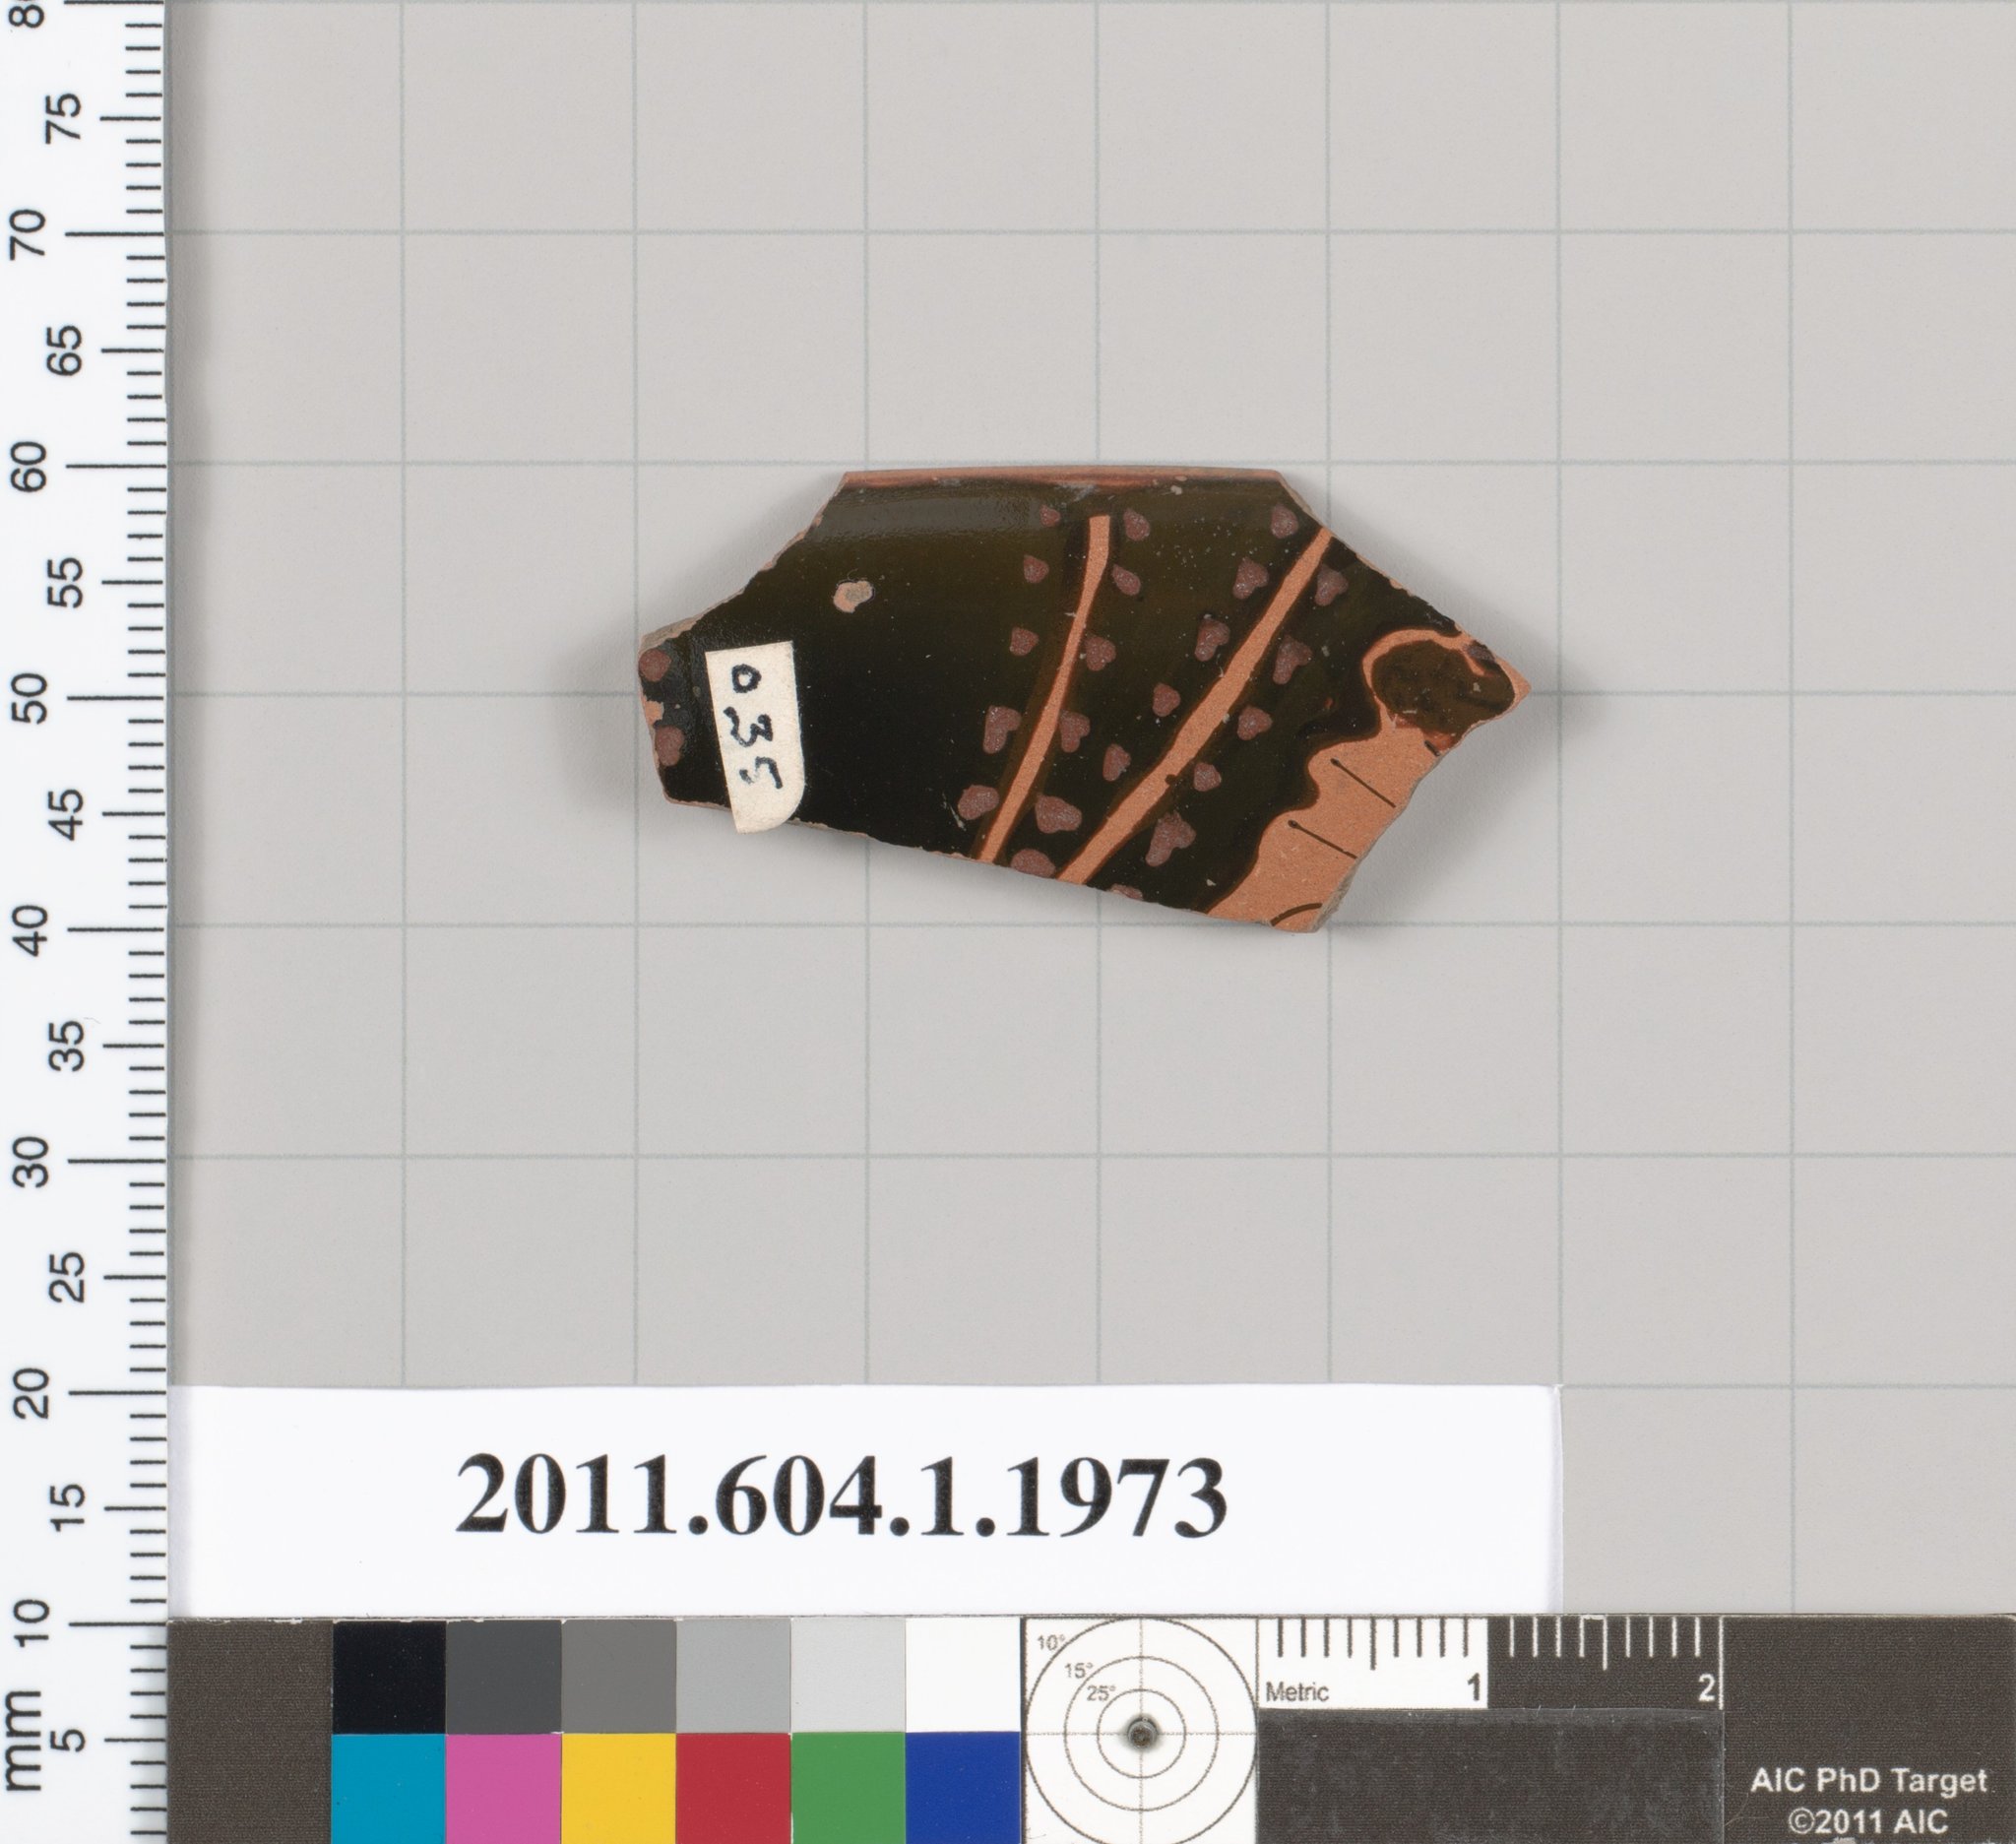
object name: kylix fragment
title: Terracotta rim fragment of a kylix (drinking cup)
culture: greek, attic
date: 475-451 BCE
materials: terracotta